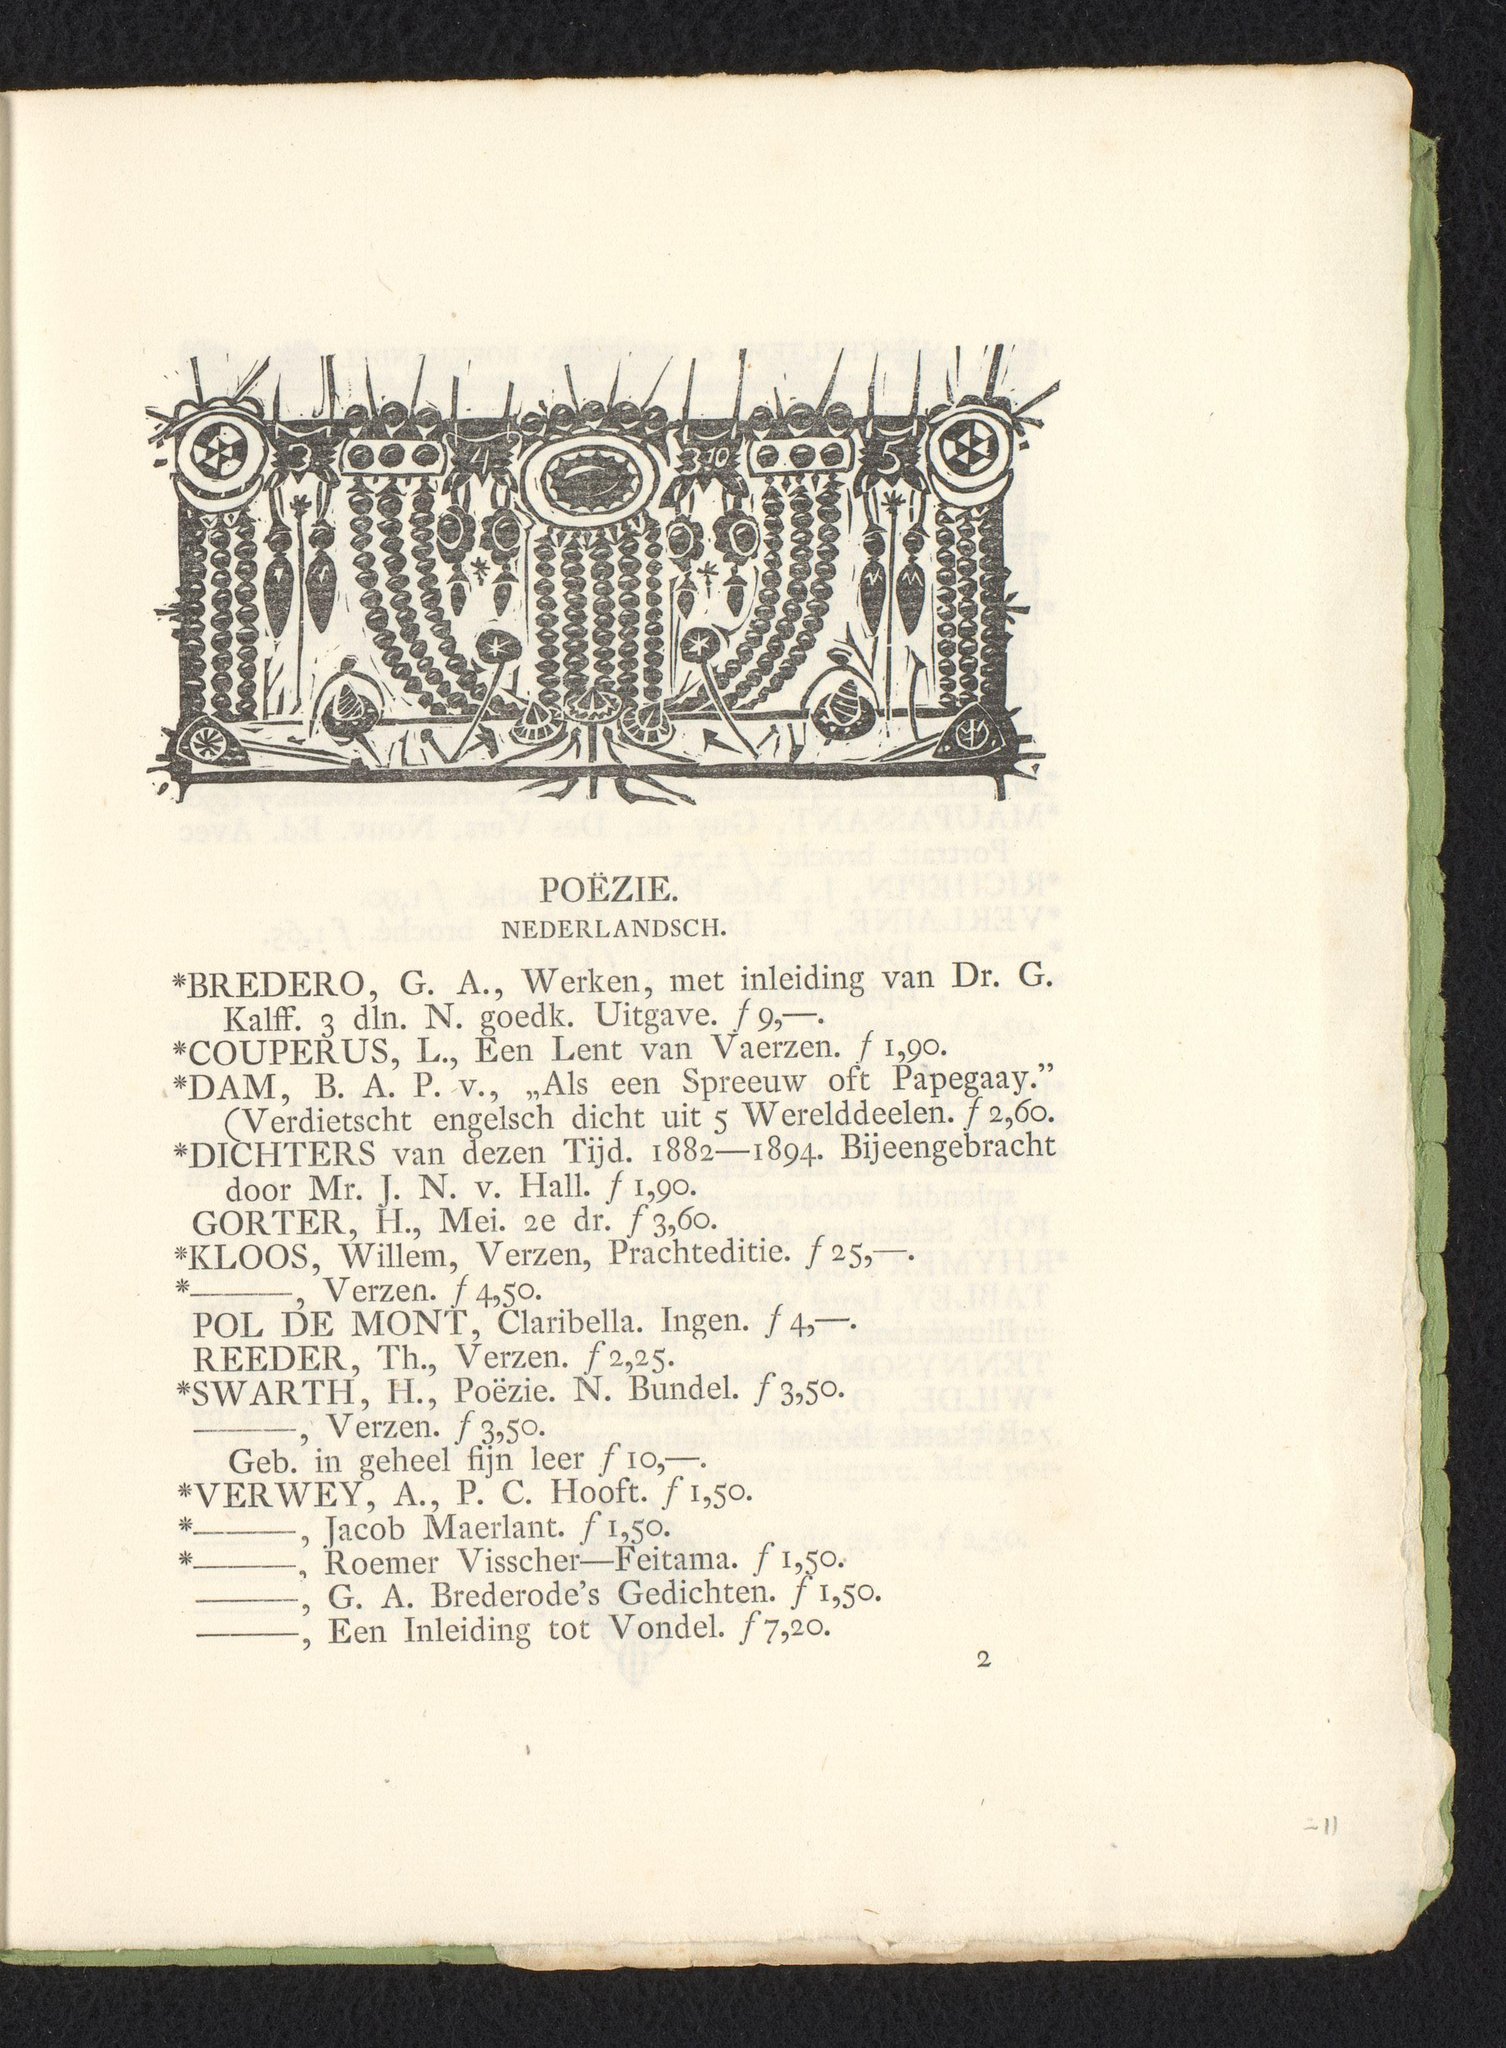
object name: print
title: Titelhoofd met sieraden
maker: gerrit willem dijsselhof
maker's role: designer, draughtsman, print maker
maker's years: 1866-1924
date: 1893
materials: paper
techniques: letterpress printing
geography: amsterdam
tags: ornaments, jewels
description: Prent uit: Catalogus van handboeken, pracht- en plaatwerken, dicht- en prozabundels en kinderliteratuur (...). Amsterdam: Scheltema & Holkema's Boekhandel, 1894, p. 17. Deze prent werd origineel ontworpen ter illustratie van: Crane, Walter. Kunst en samenleving. [Vertaald uit het Engels door] Jan Veth. Amsterdam: Scheltema & Holkema's Boekhandel, 1894 [1893], p. 37.